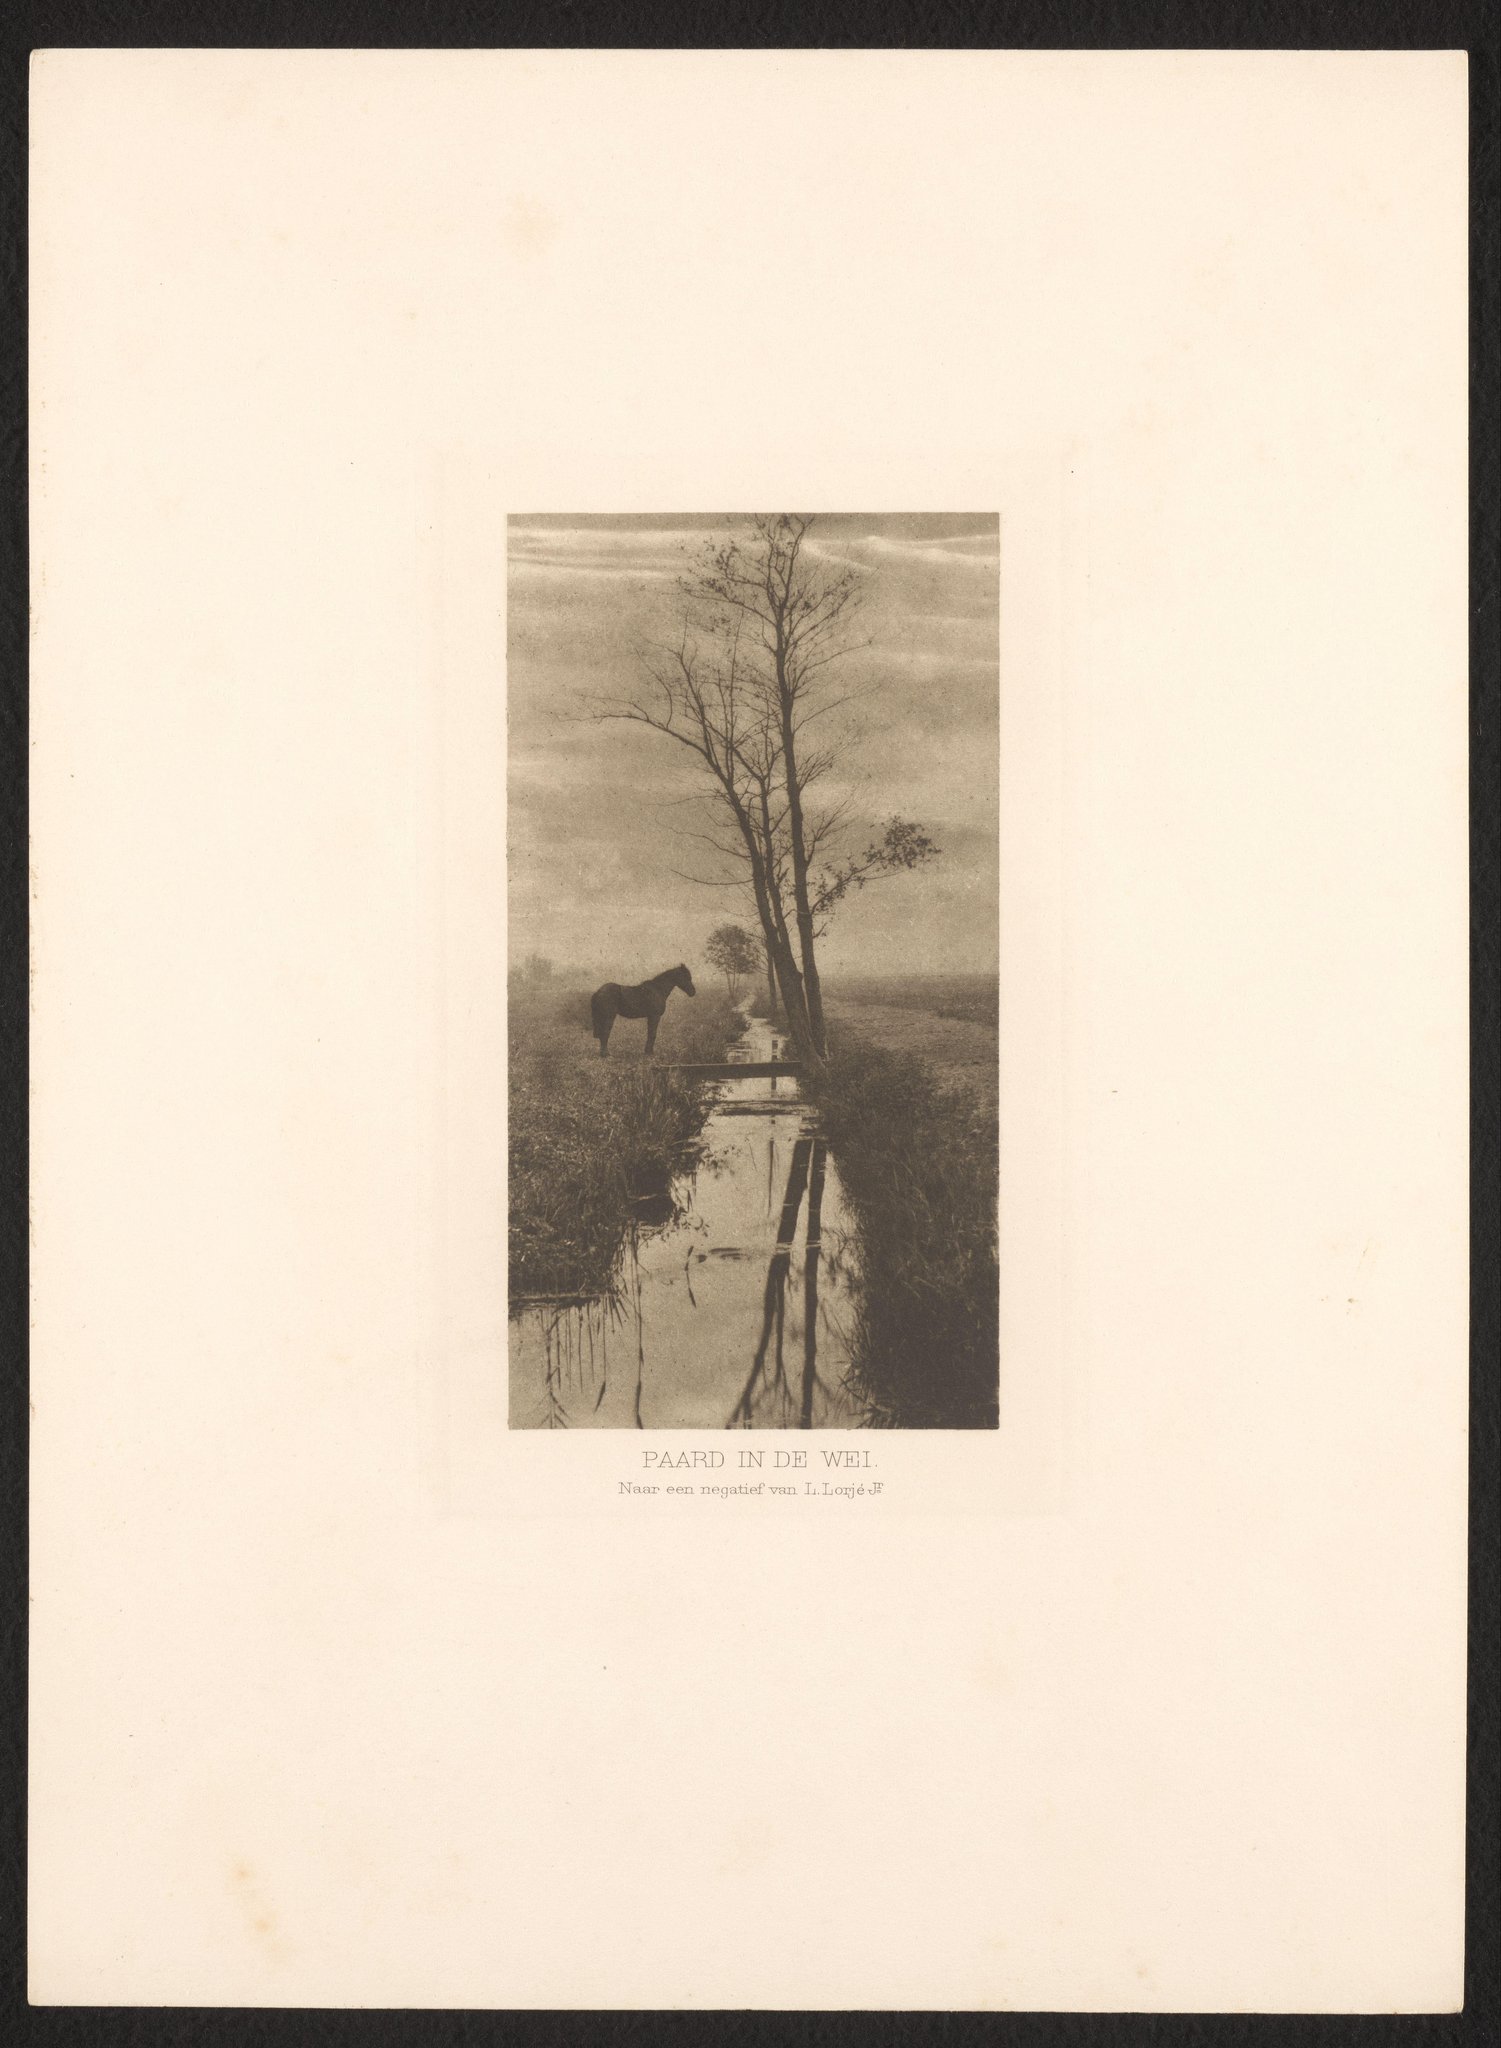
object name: photomechanical print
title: Paard in een weiland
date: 1900-1905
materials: paper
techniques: photoaquatint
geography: netherlands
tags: trees, meadow, pasture, horse, small canal, ditch